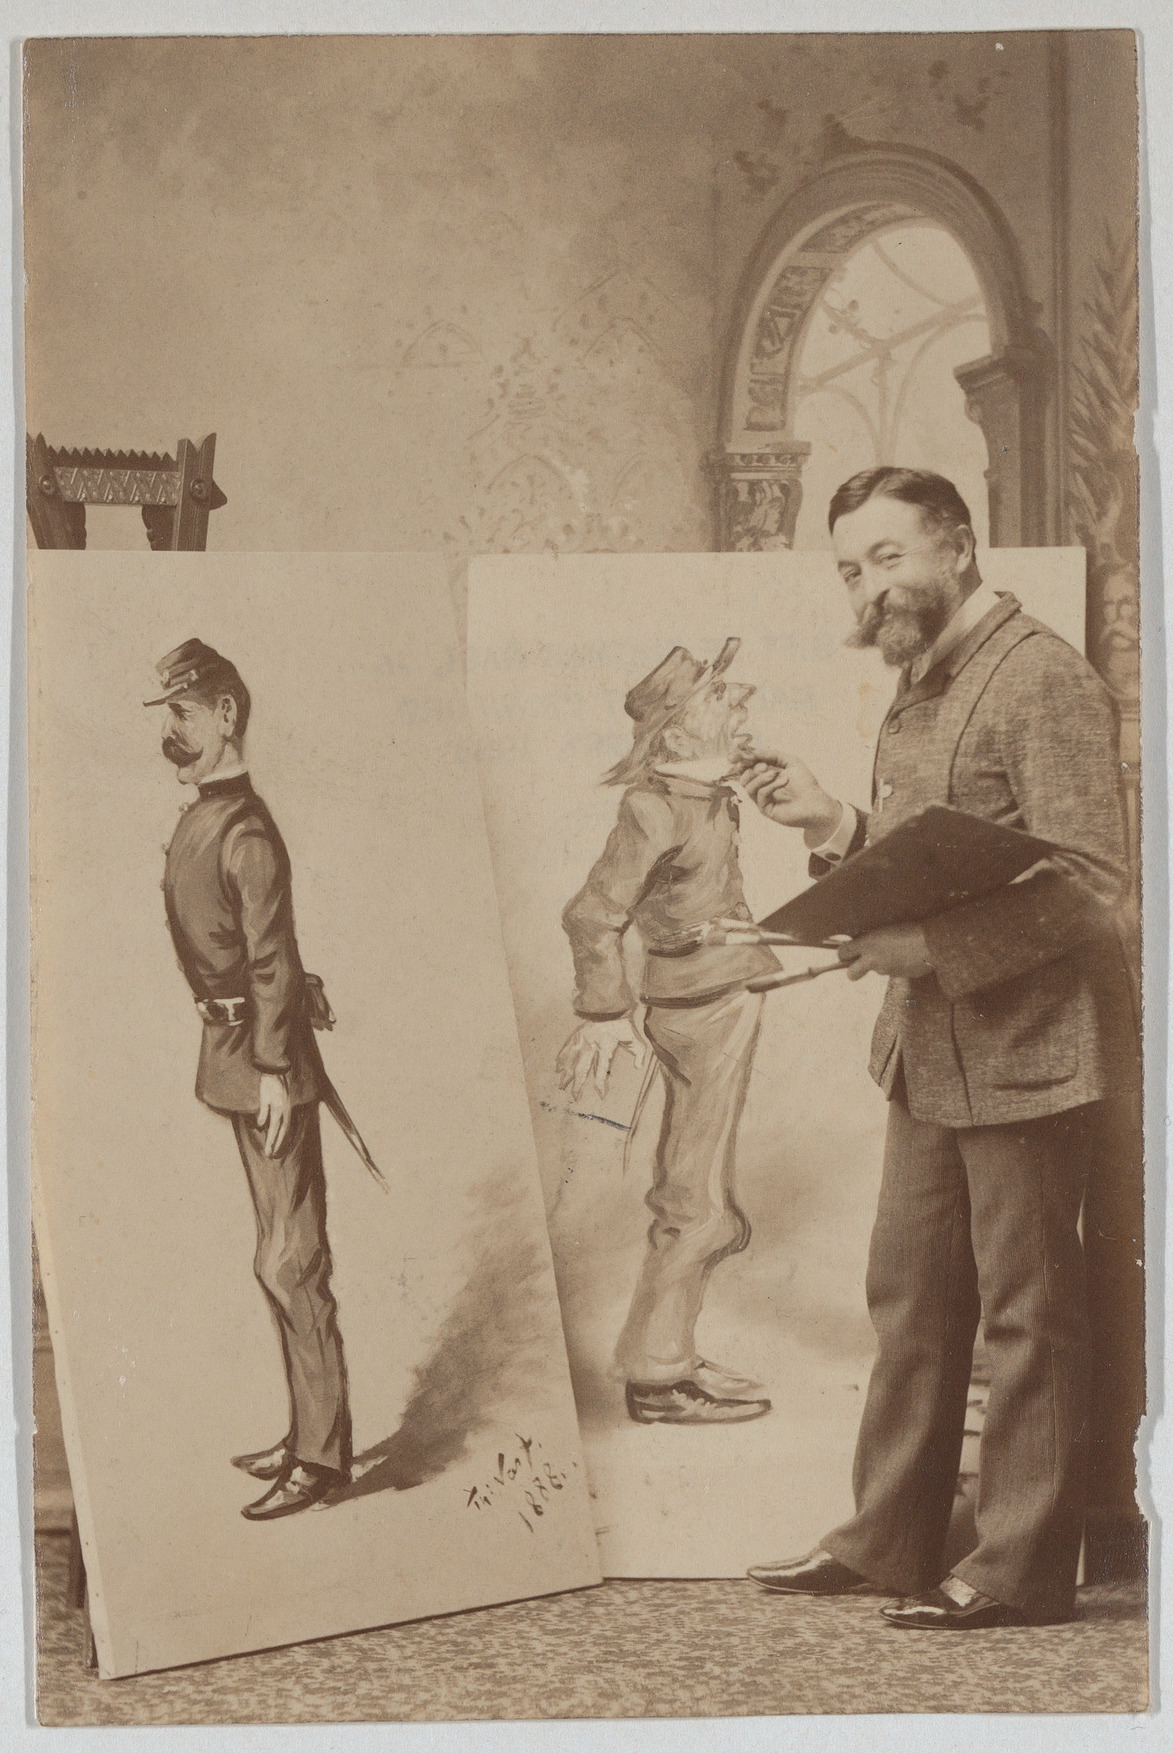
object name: print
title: Full-length Portrait of Thomas Nast with Two Caricatures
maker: thomas nast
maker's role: artist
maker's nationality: american, born germany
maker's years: 1840-1902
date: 1888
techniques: photography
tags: painting,men,portraits